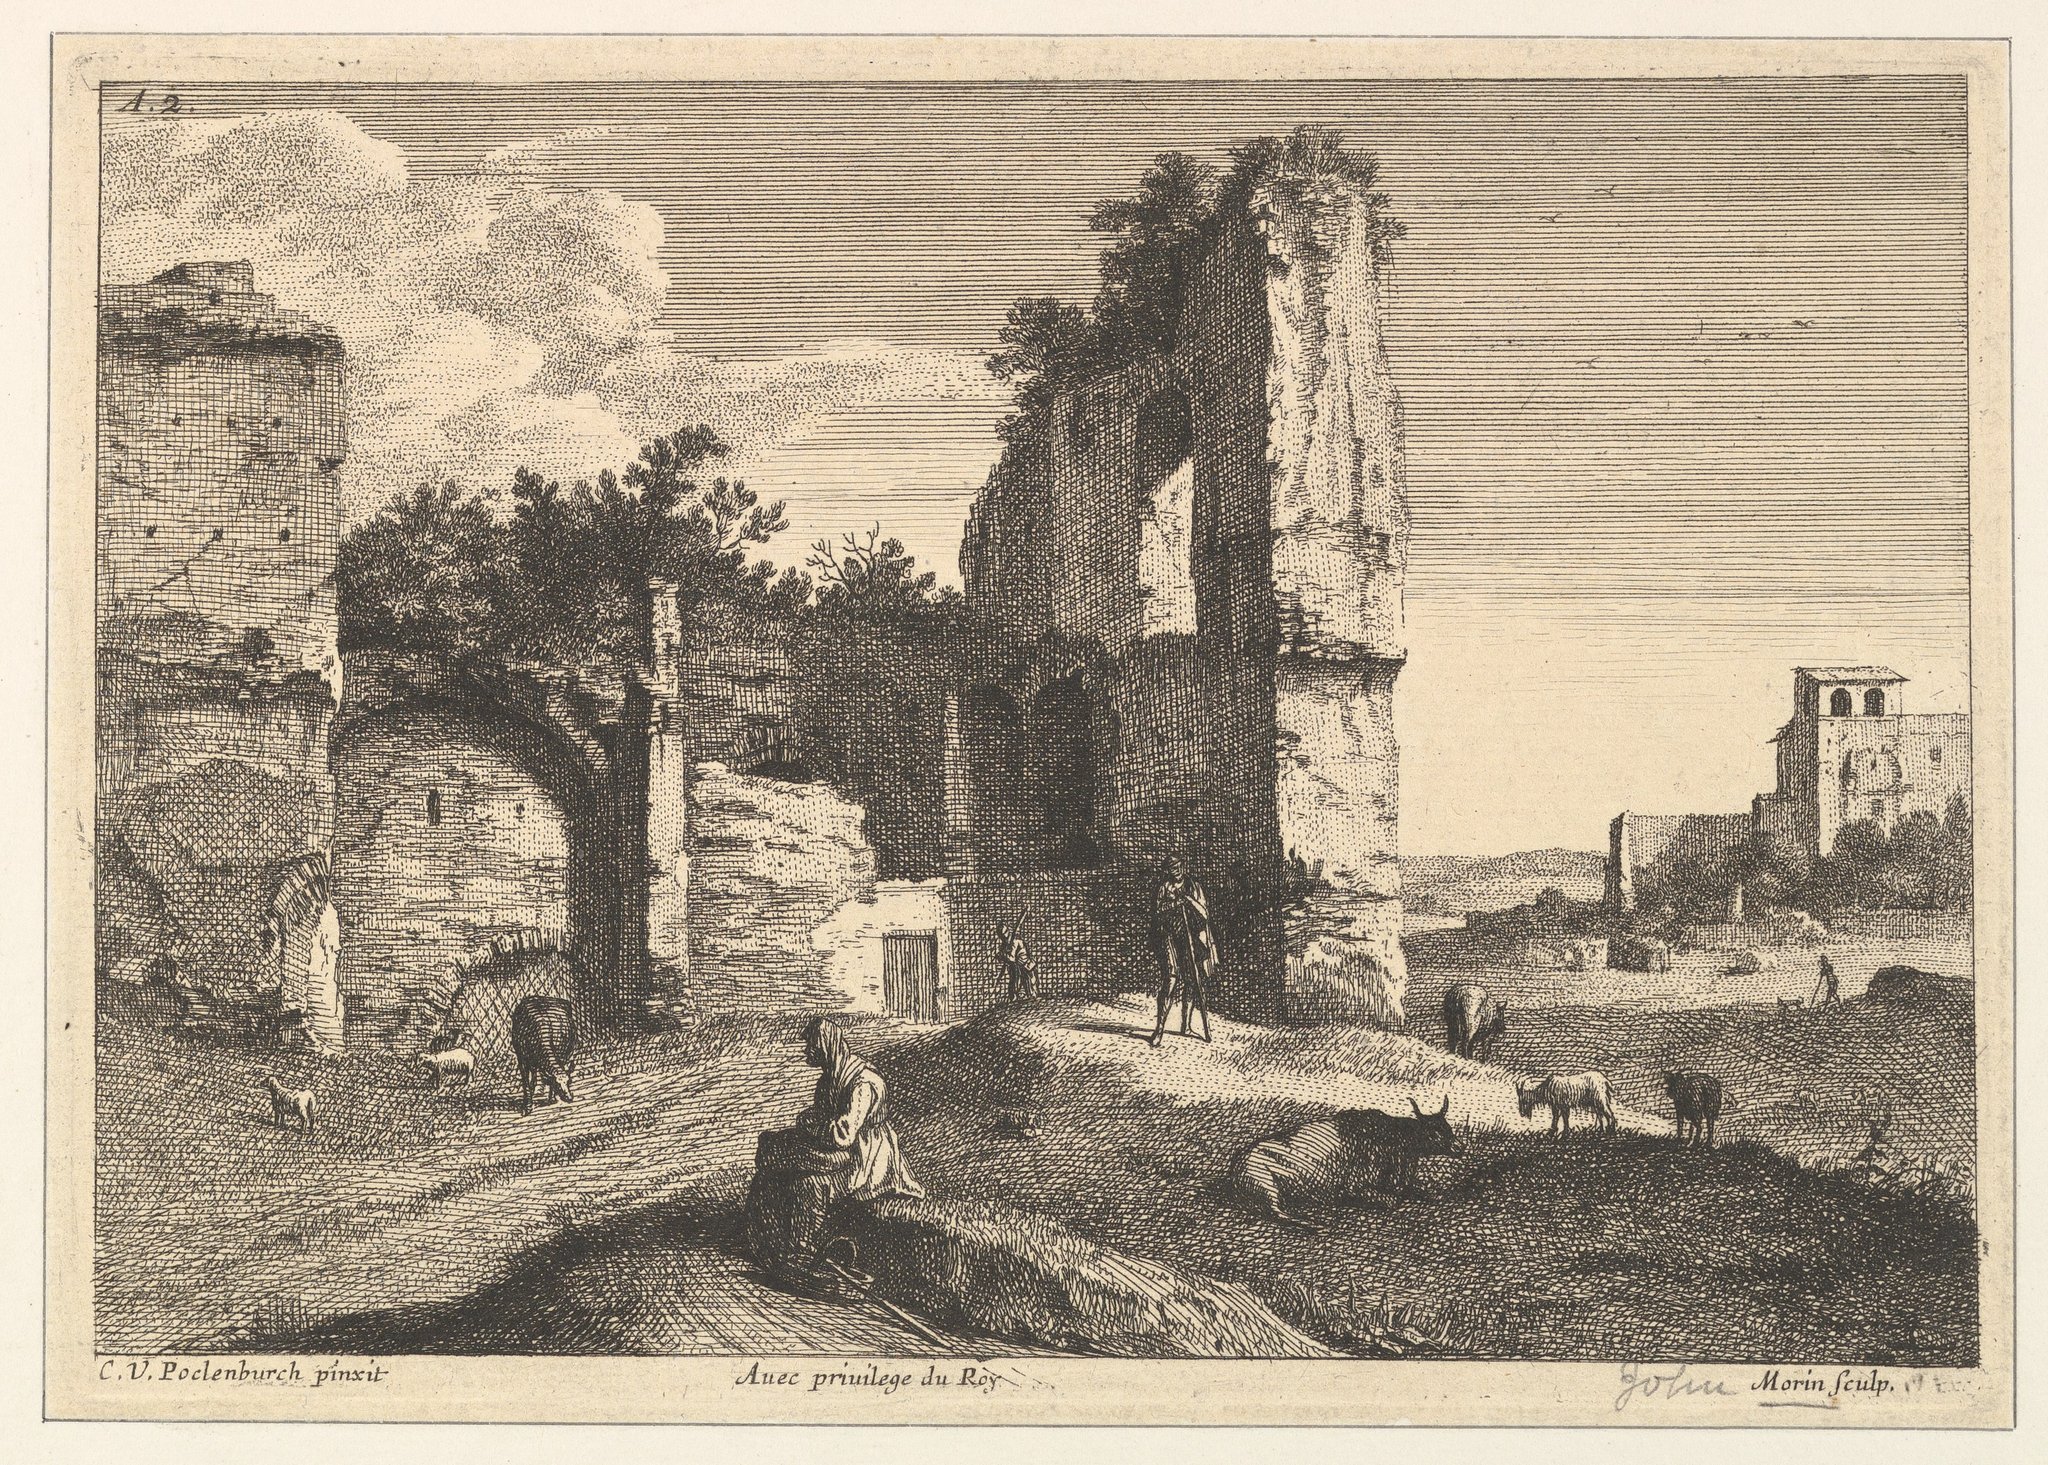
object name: print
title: La Vieille Femme Assise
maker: jean morin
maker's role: etcher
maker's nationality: french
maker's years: 1605-1650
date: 1605-1650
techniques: etching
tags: ruins,cows